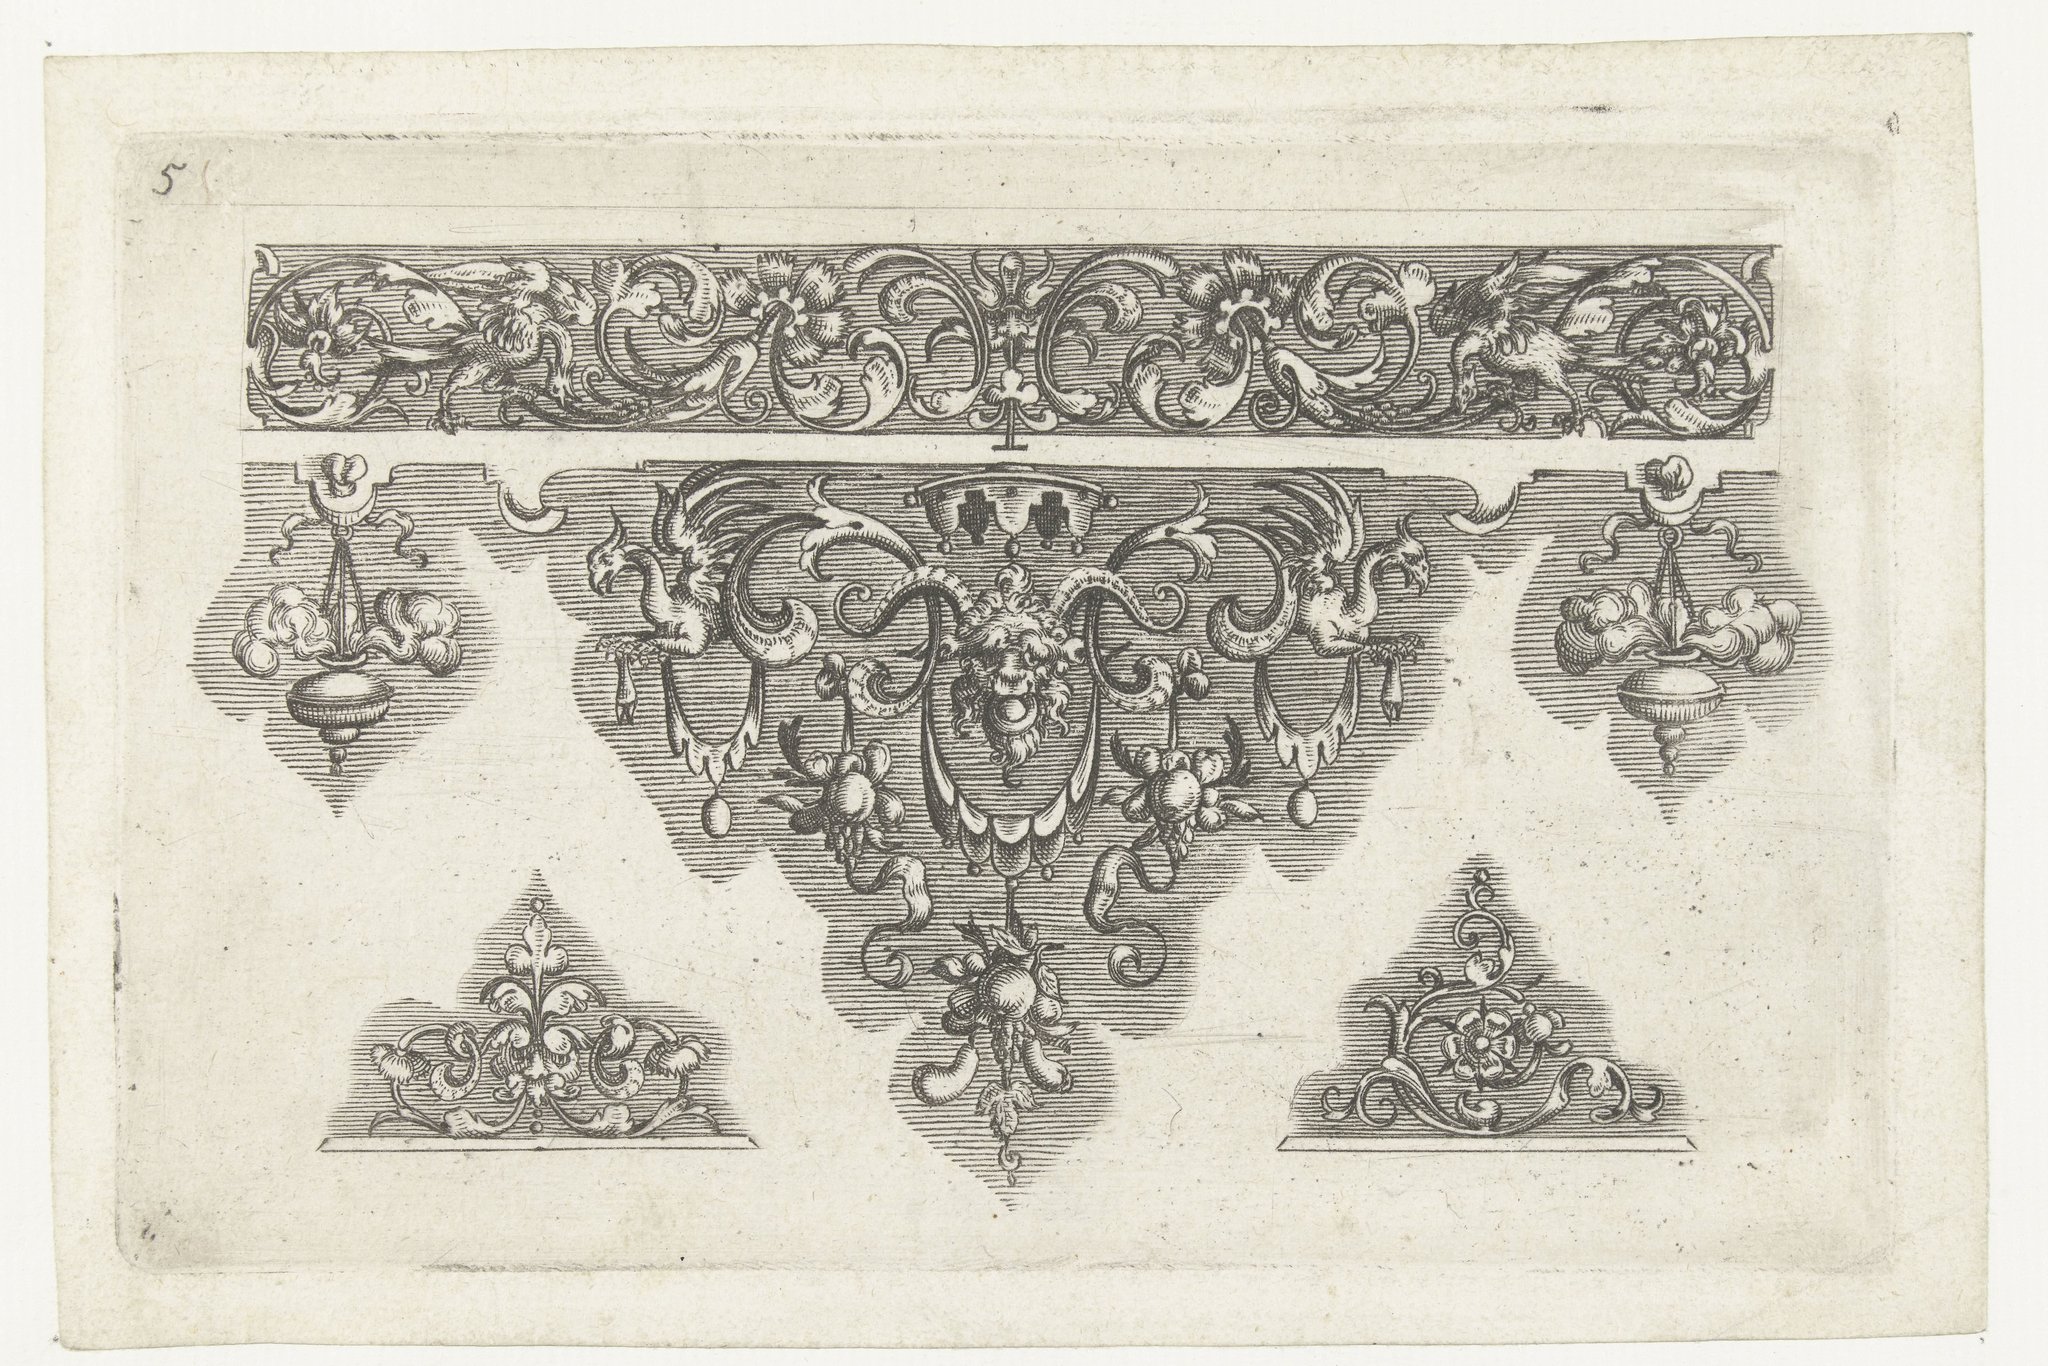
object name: ornament print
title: Tegenzijdige kopieën naar prenten met decoratie voor randen en bekers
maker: Anonymous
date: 1571-1639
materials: paper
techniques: engraving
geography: germany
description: Rand met bovenaan een fries. Zowel links als rechts pikt een vogel in een rank. Daaronder een mascaron in de vorm van een saterkop, tussen twee draken. Eén van 6 deels genummerde bladen. Tegenzijdige kopieën naar de prenten van de onder Orn Cat I-317 beschreven serie.